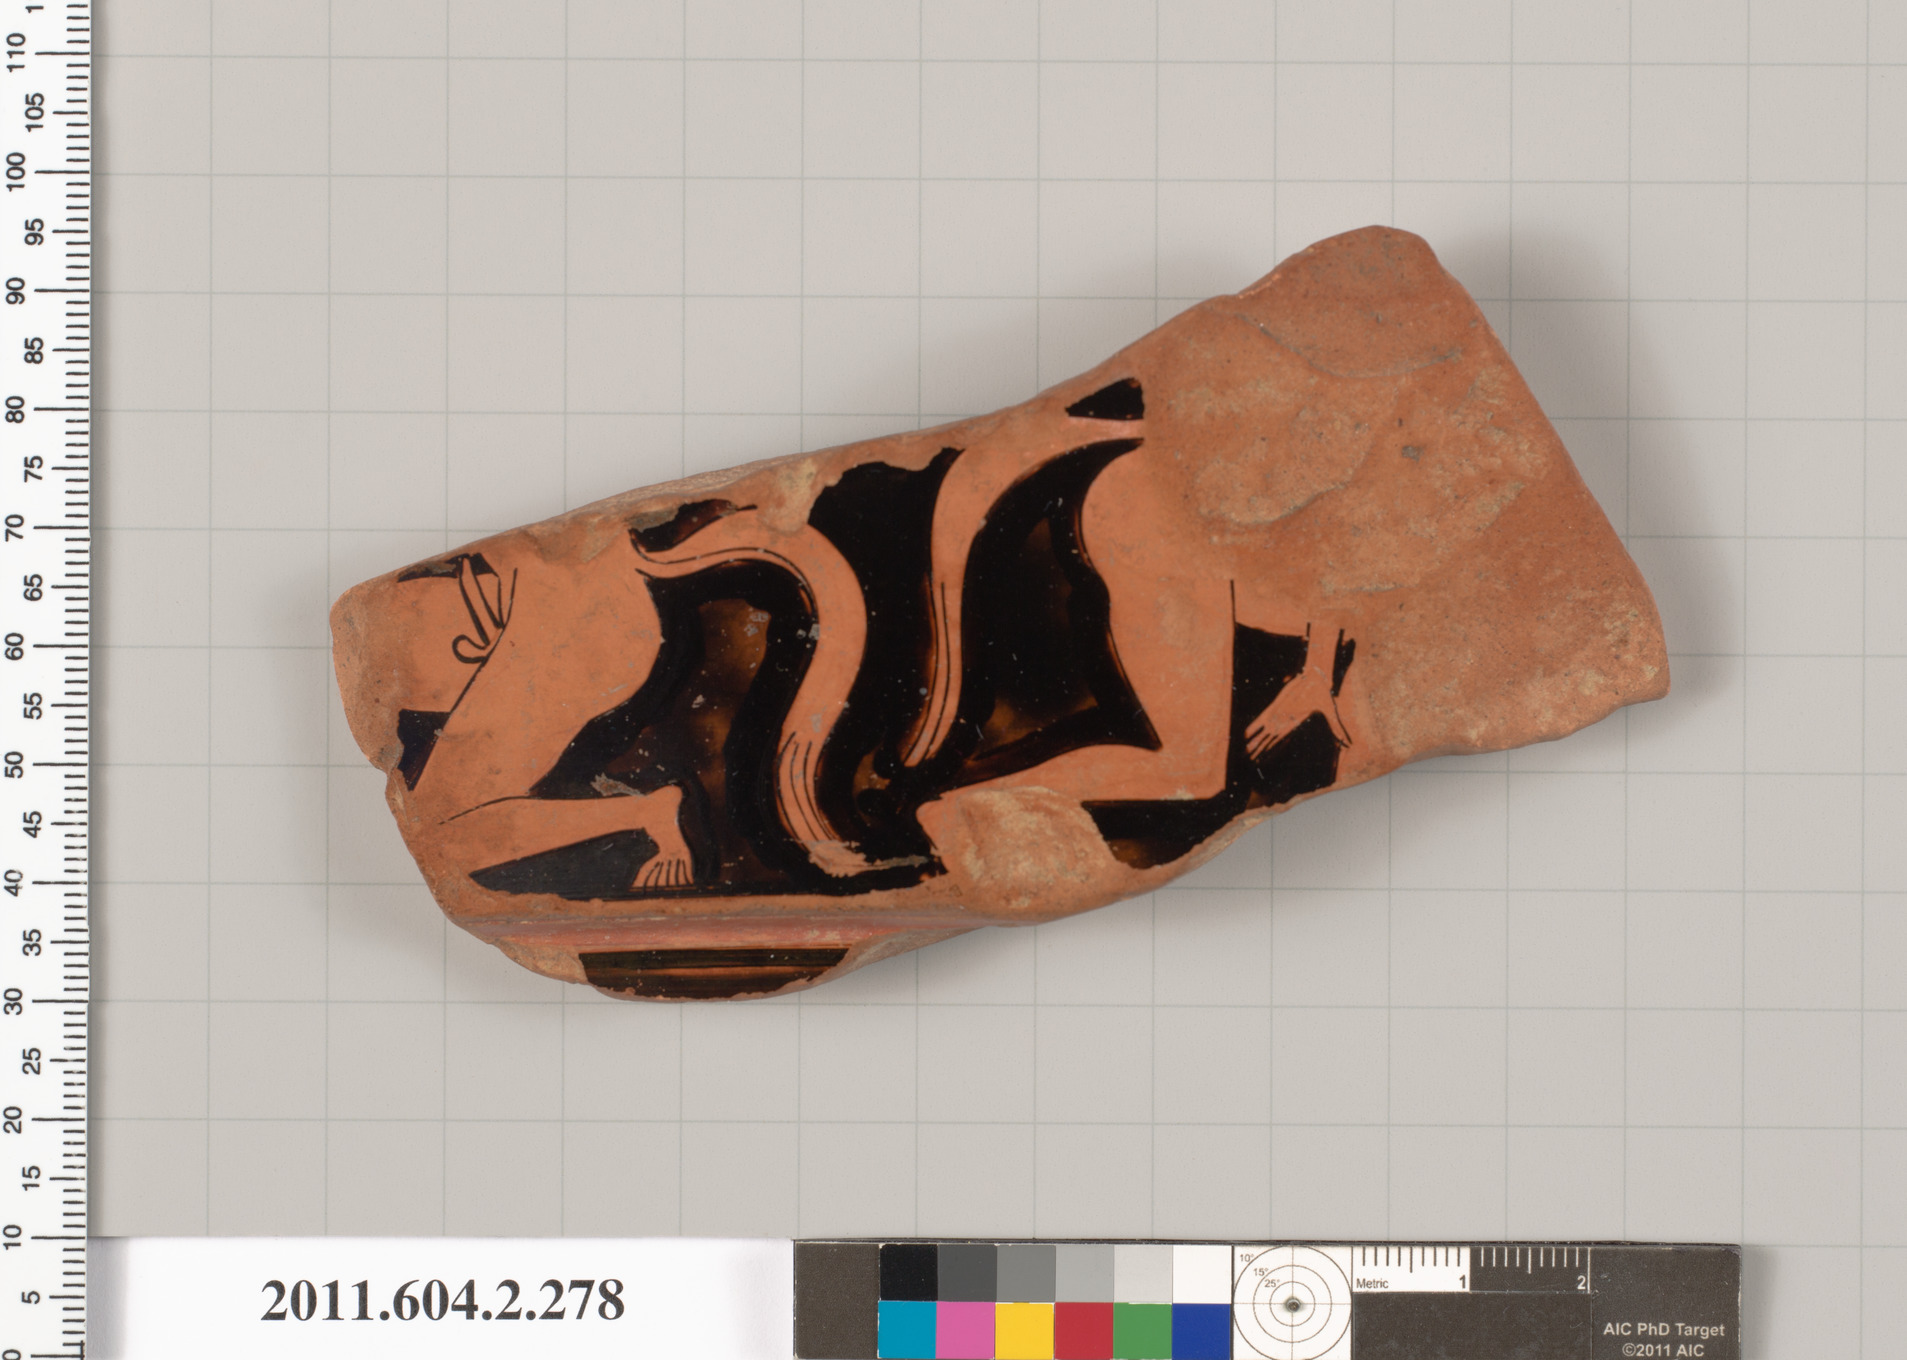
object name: volute krater fragment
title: Terracotta fragment of a volute-krater (bowl for mixing wine and water)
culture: greek, attic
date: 490-470 BCE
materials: terracotta